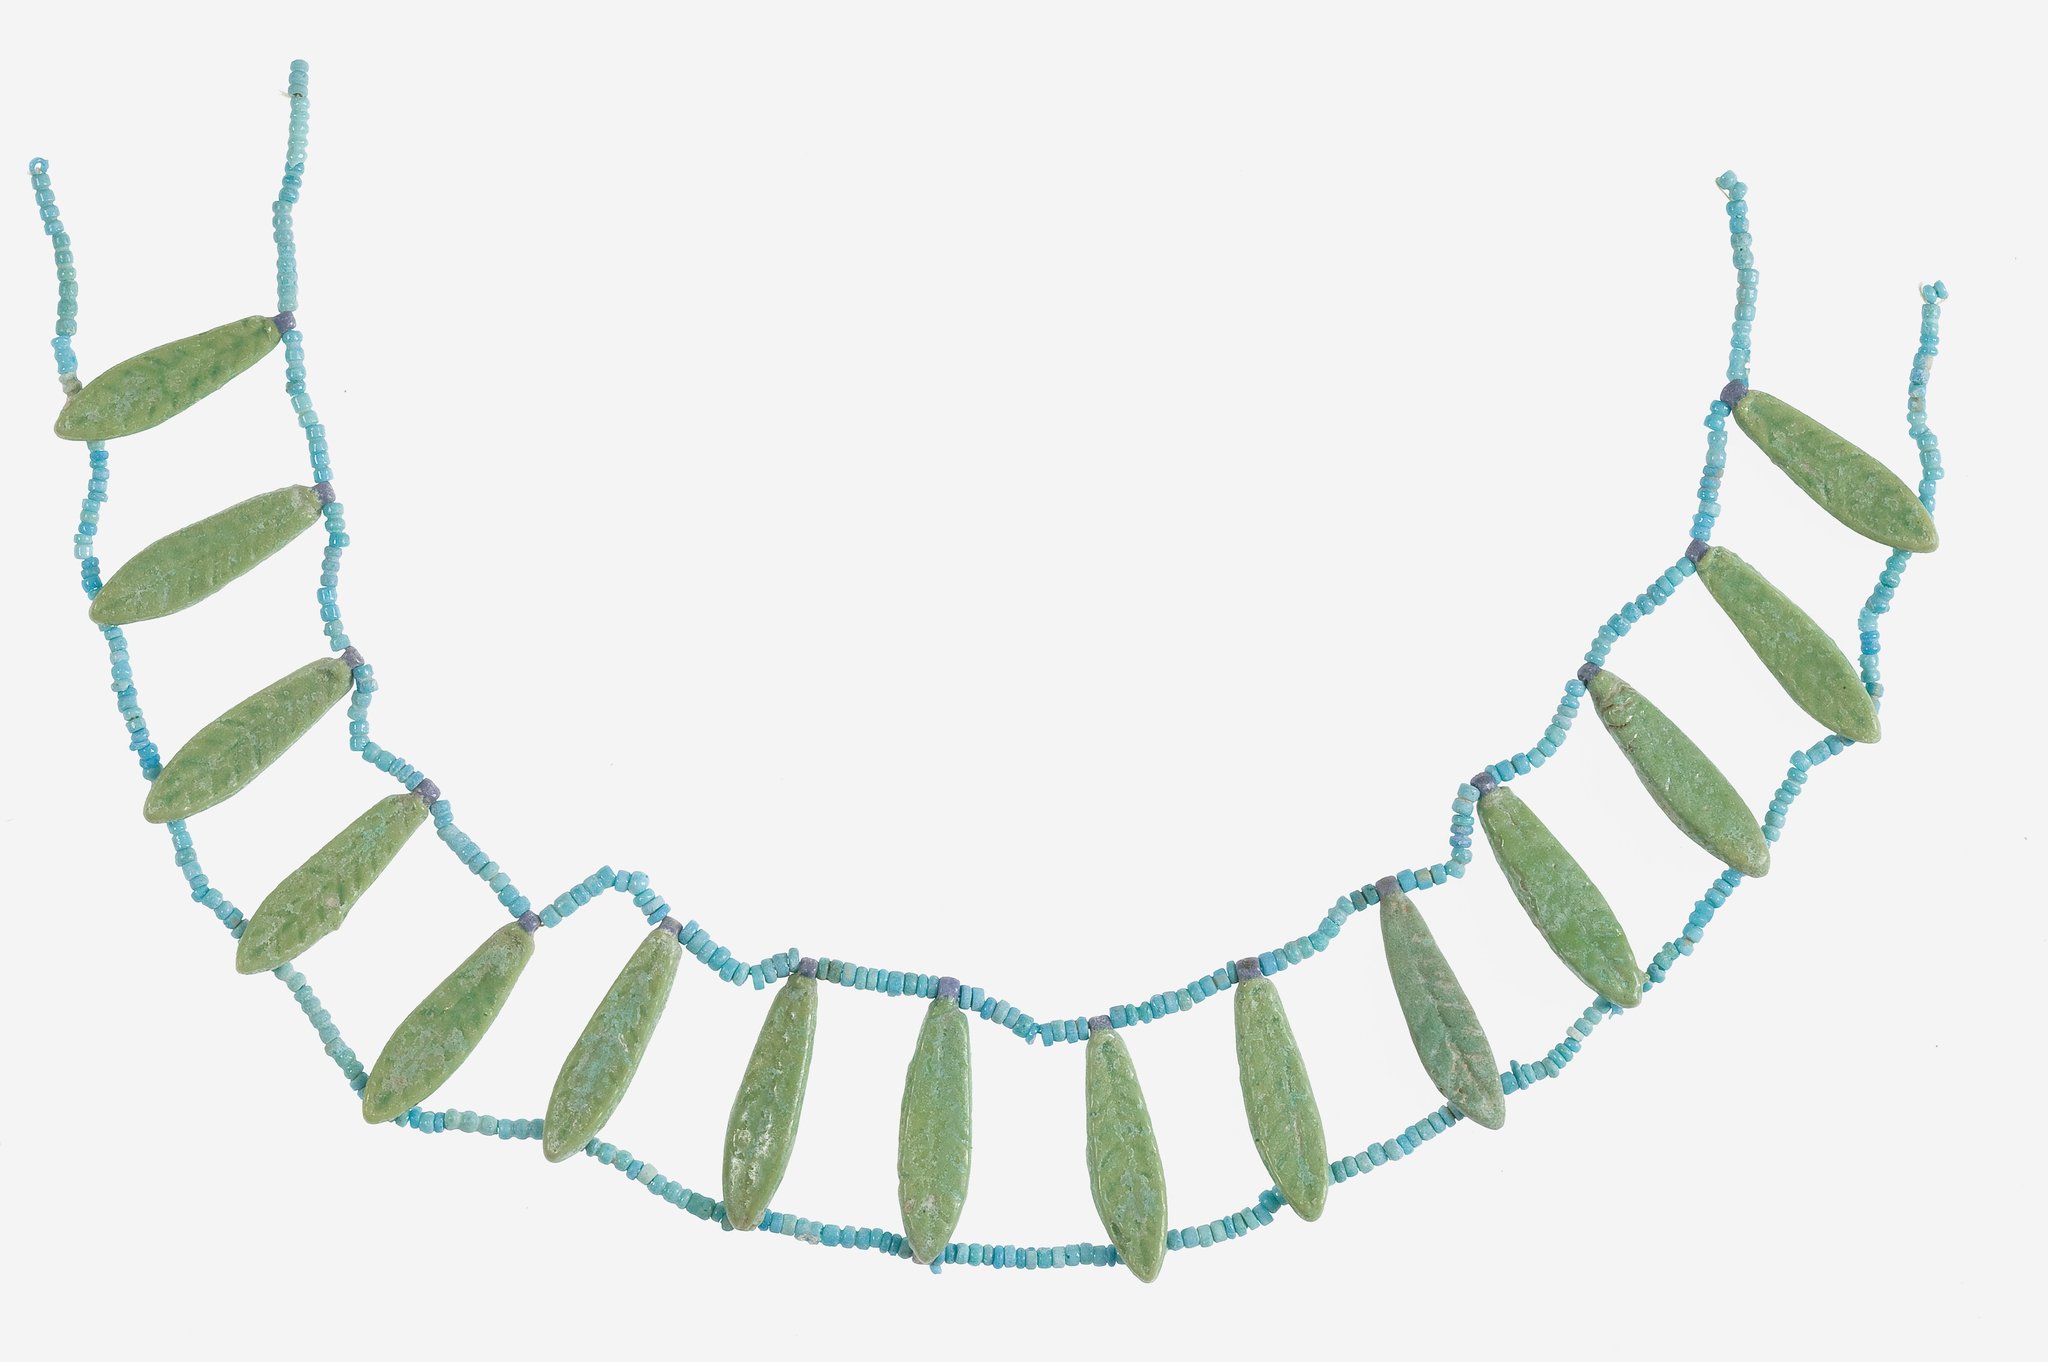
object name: bead, leaf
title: String of Leaf Beads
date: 1390-1352 BCE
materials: faience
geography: egypt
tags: leaves